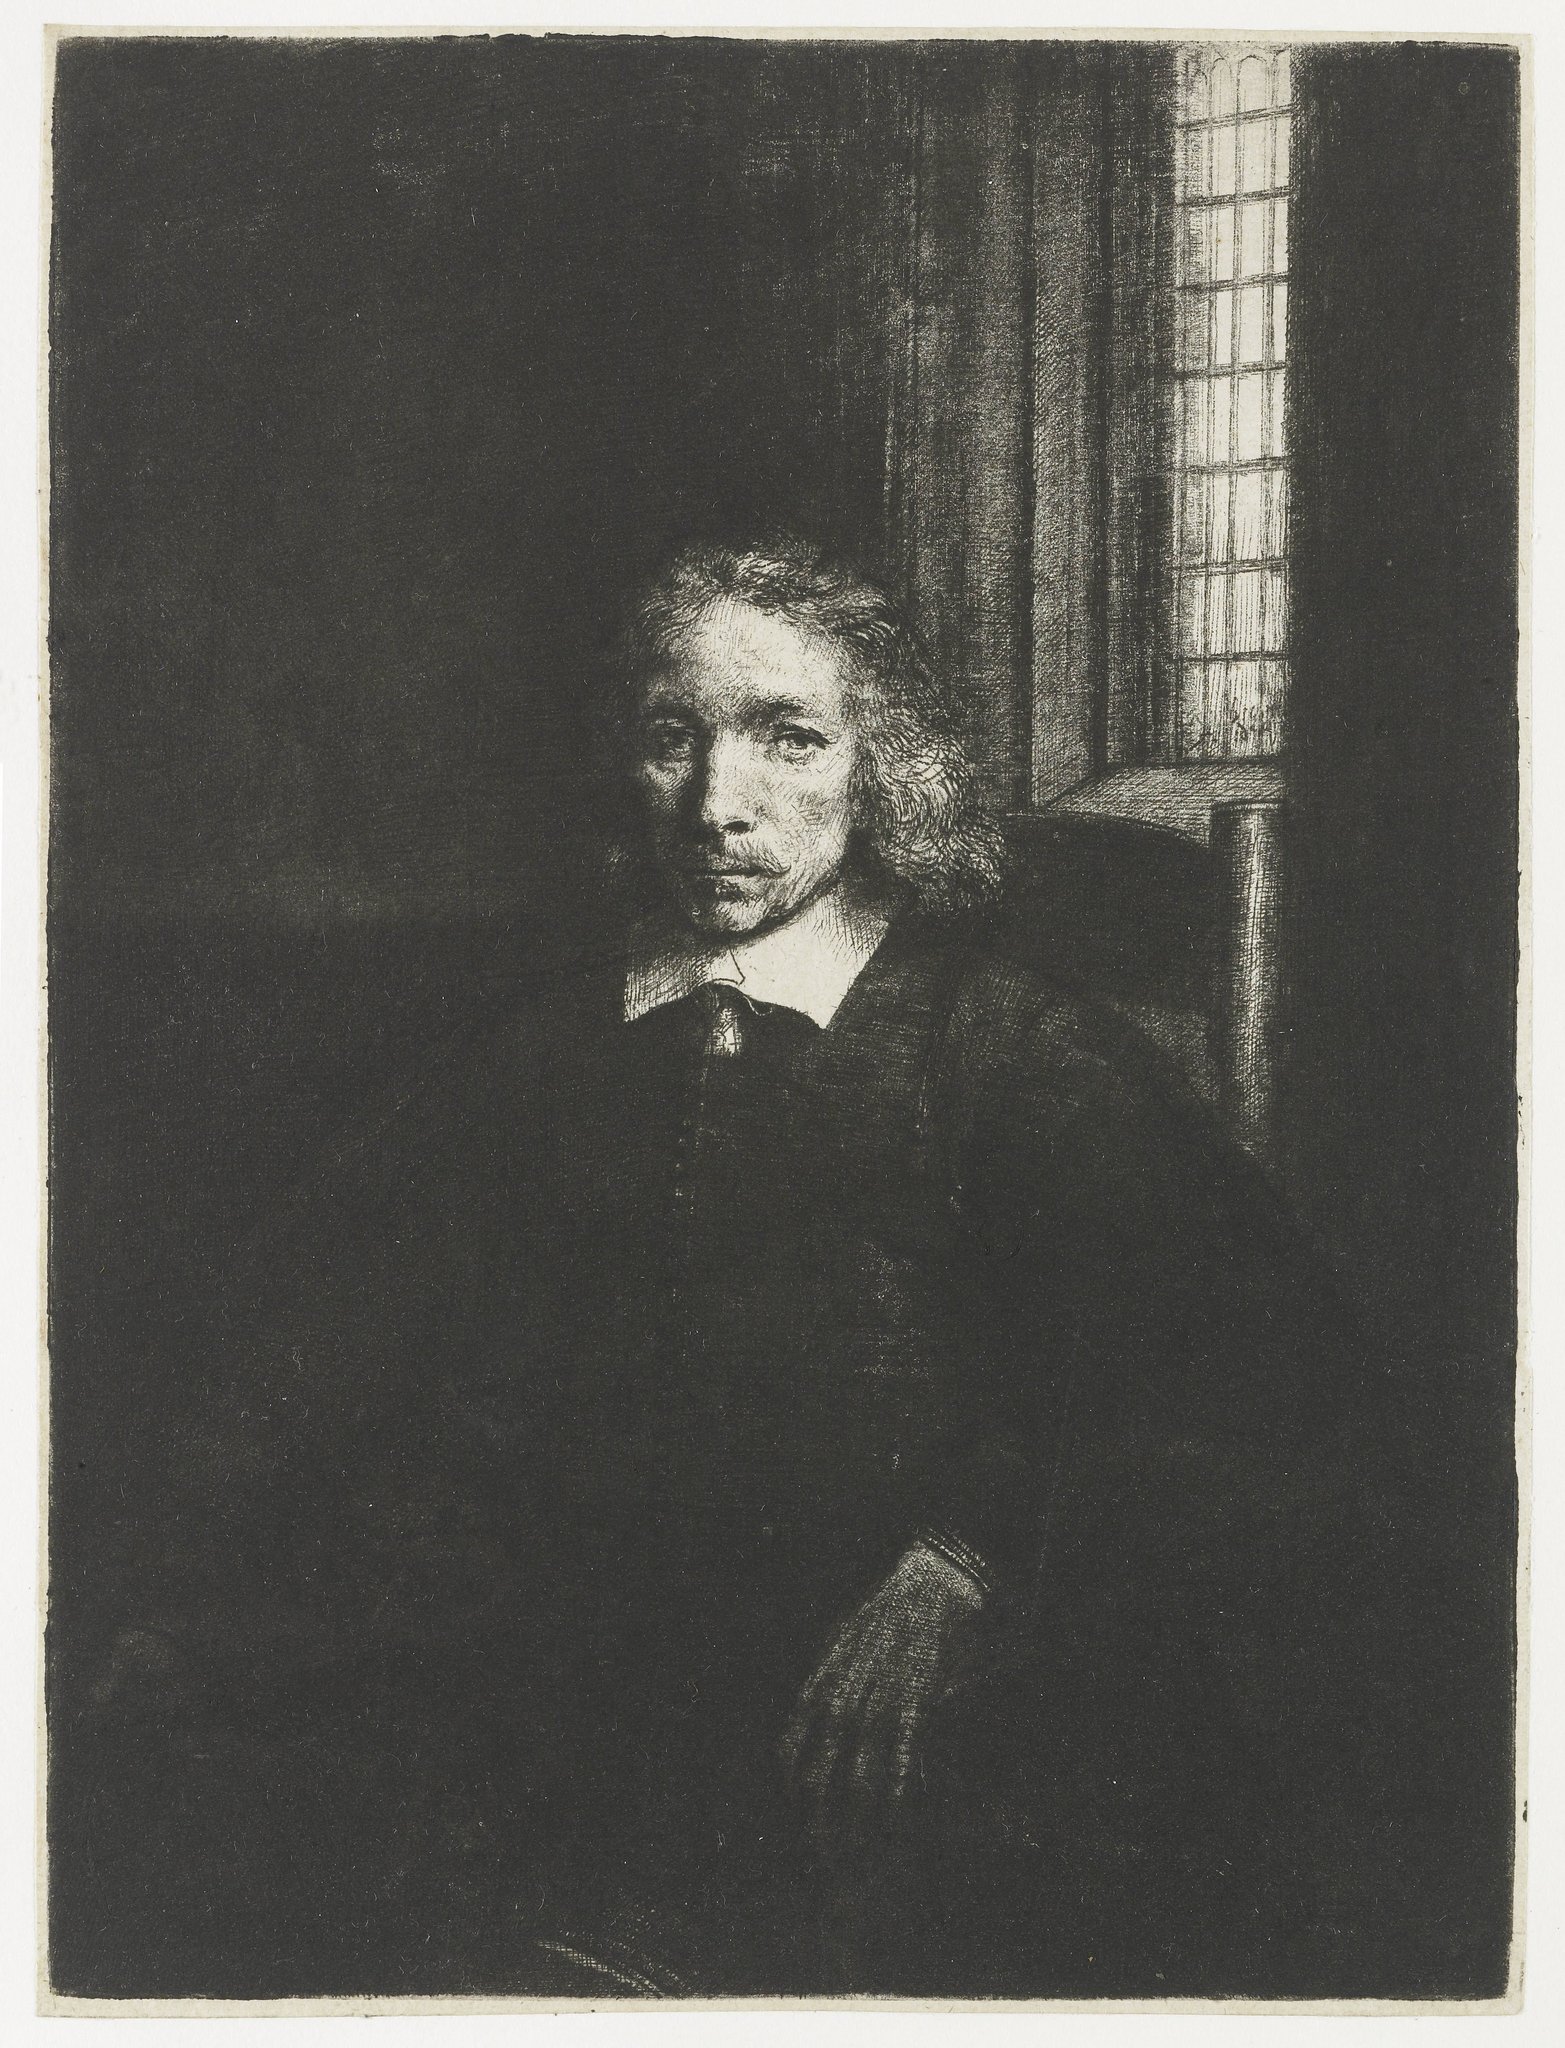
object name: print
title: Pieter Haaringh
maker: rembrandt van rijn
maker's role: draughtsman, painter, print maker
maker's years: 1606-1669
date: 1655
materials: paper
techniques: drypoint, etching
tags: pieter haringh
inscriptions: signature and date: ‘Rembrandt f 1655’, collector's mark: Lugt 240